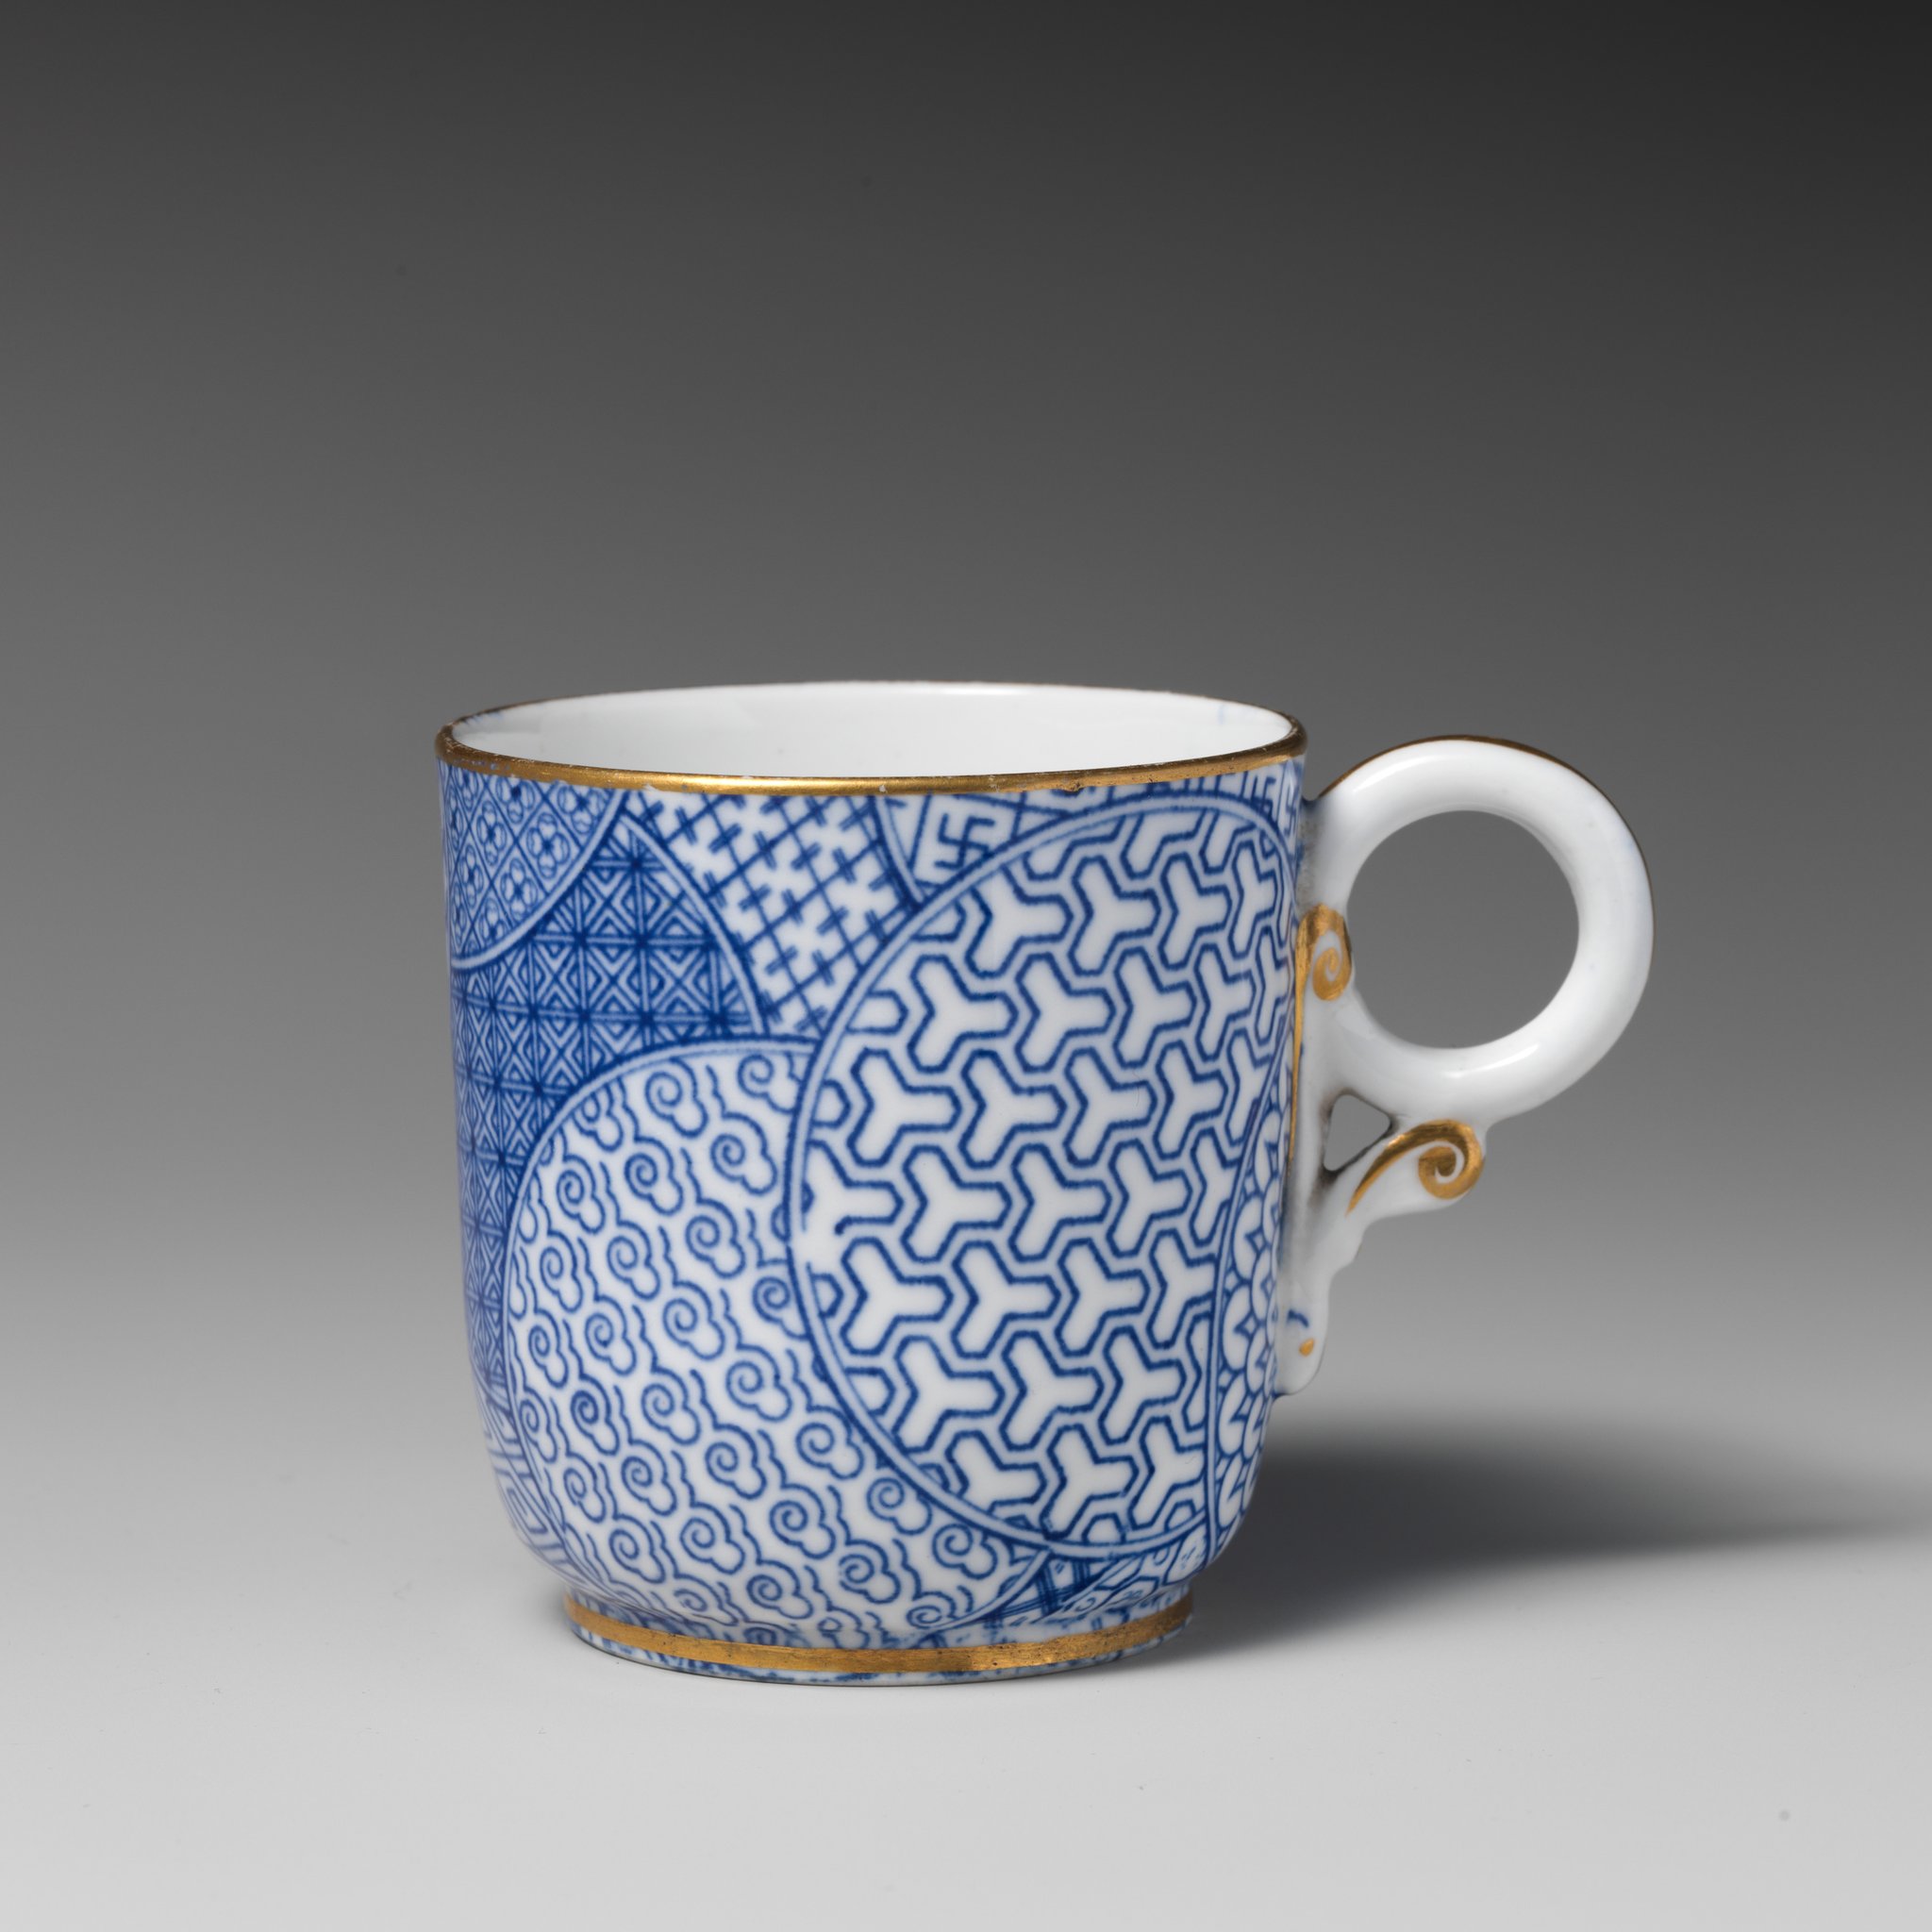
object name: teacup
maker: worcester factory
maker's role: maker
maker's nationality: british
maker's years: 1751-2008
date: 1877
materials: bone china